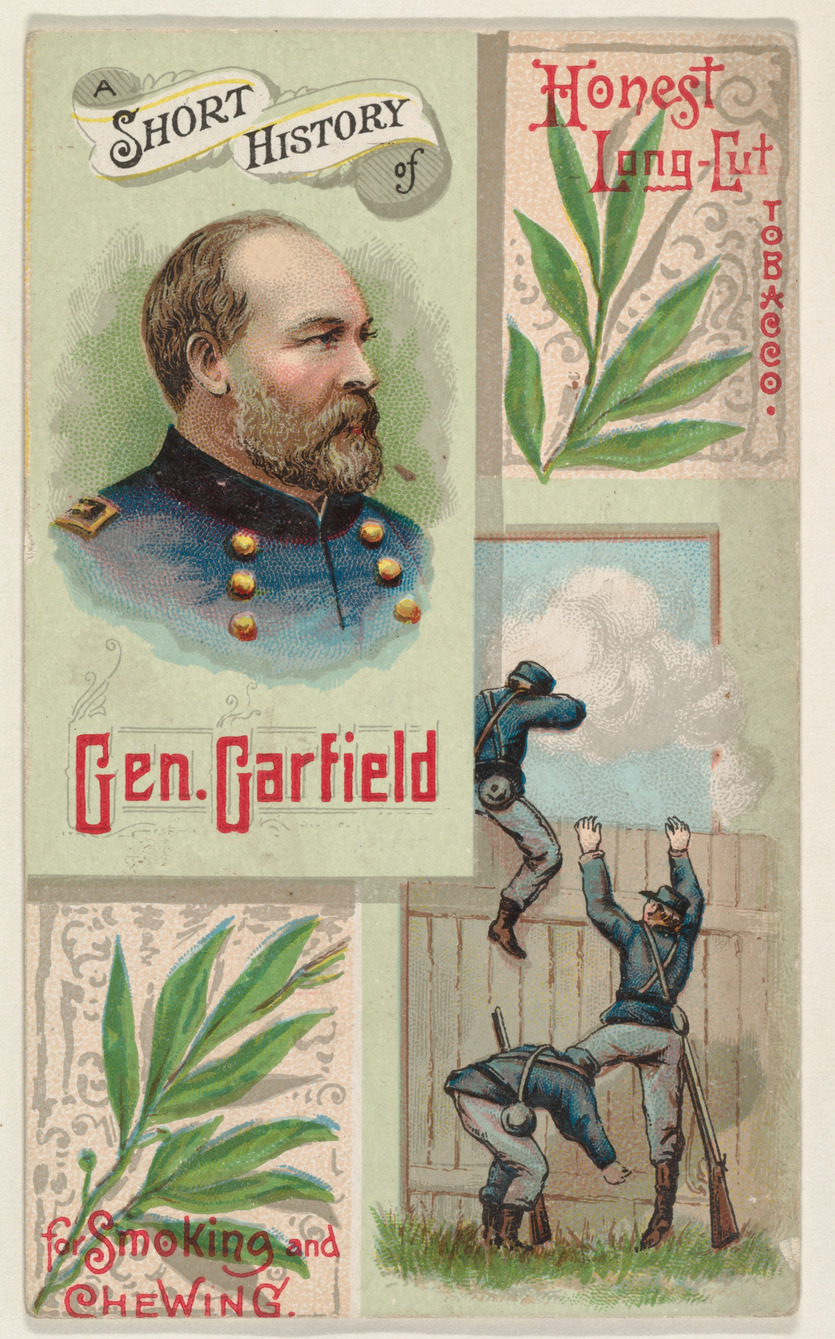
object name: print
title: A Short History of General Garfield, from the Histories of Generals series (N114) issued by W. Duke, Sons & Co. to promote Honest Long Cut Smoking and Chewing Tobacco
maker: w. duke, sons & co.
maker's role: publisher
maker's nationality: american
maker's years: 1870-1920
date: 1888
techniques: color lithograph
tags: men,profiles,generals